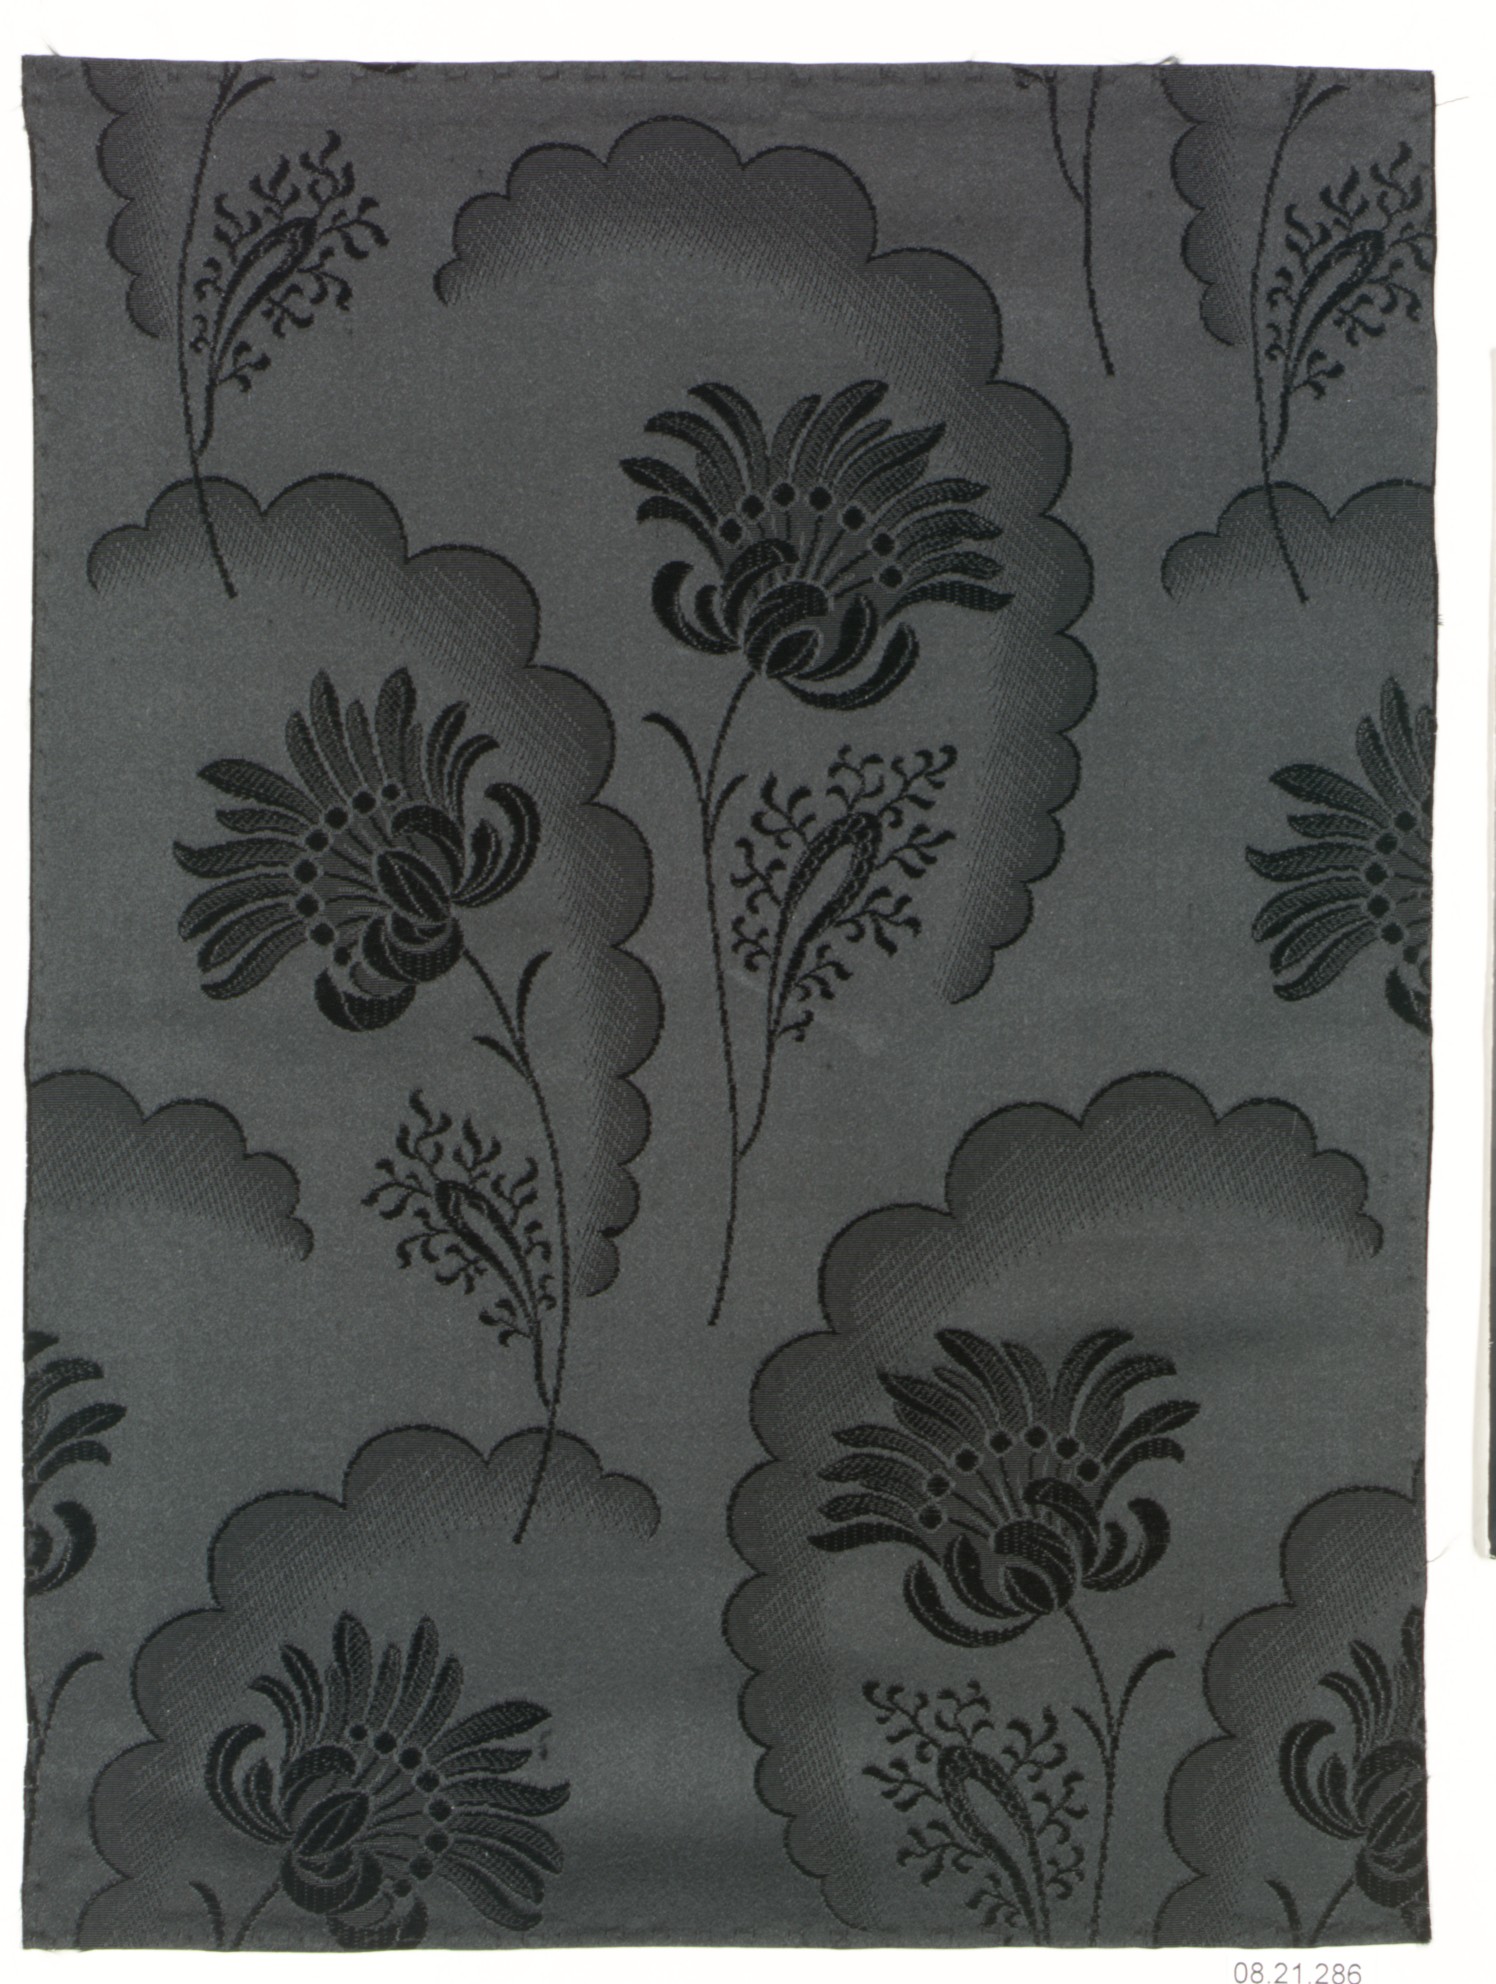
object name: textile sample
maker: Anonymous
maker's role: designer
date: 1900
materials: silk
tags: flowers